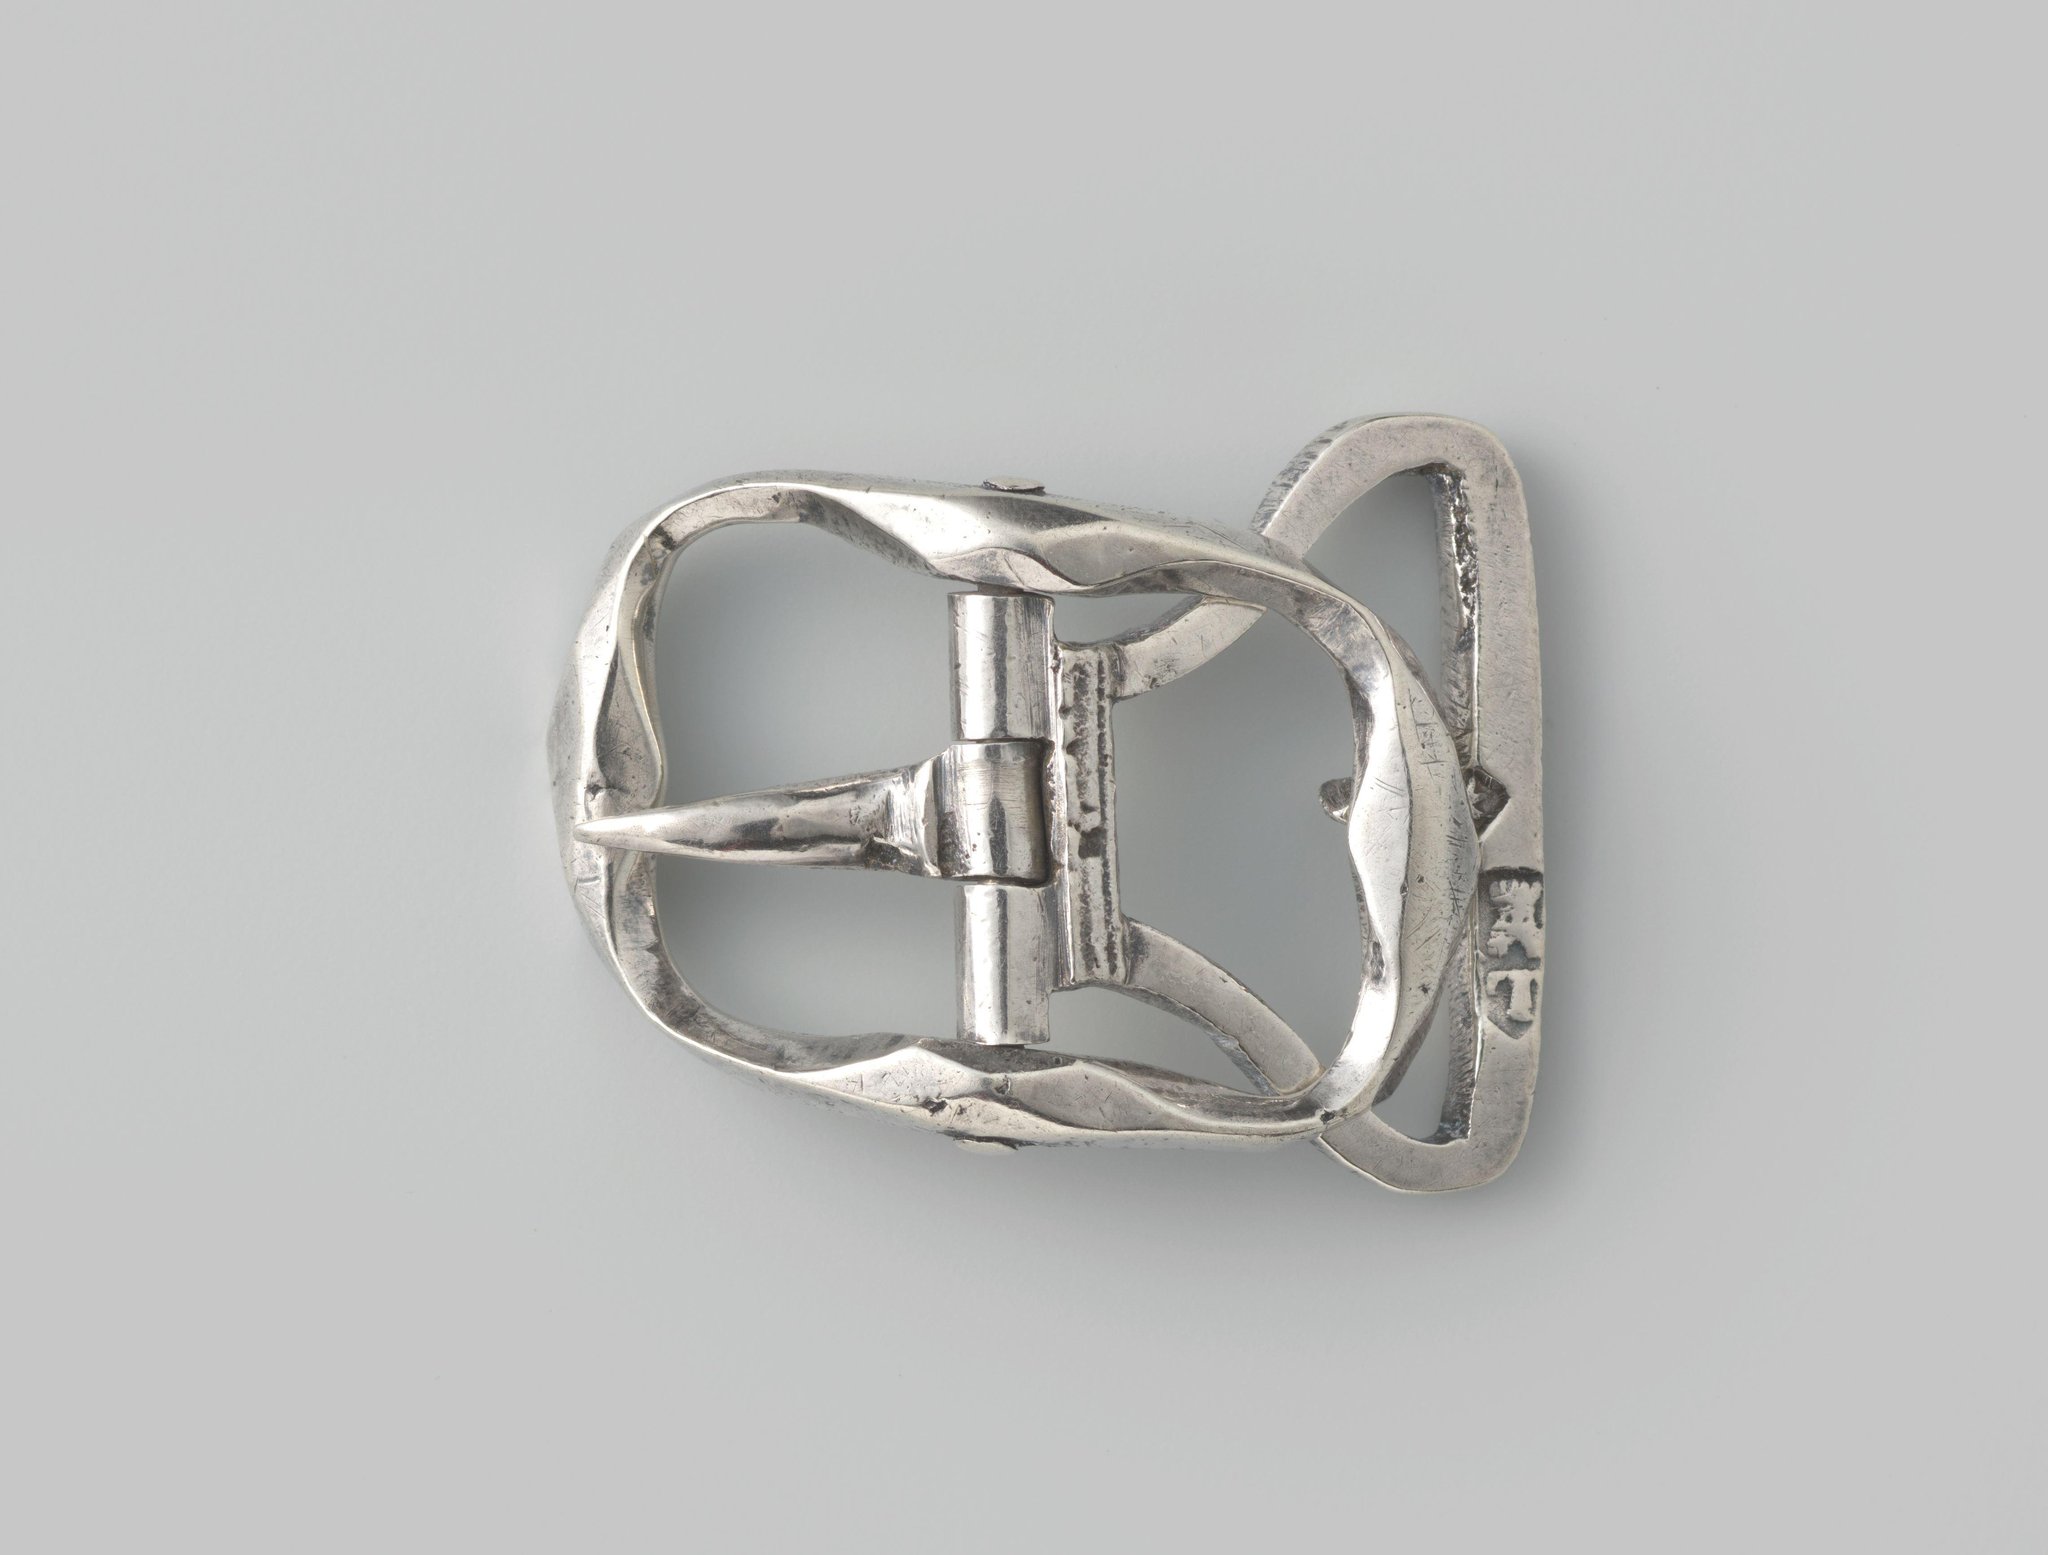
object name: broekgesp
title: Zilveren broekgesp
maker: johannes kuypers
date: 1731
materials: silver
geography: middelburg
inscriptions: maker's mark, date letter: ‘T (=1731)’, town mark